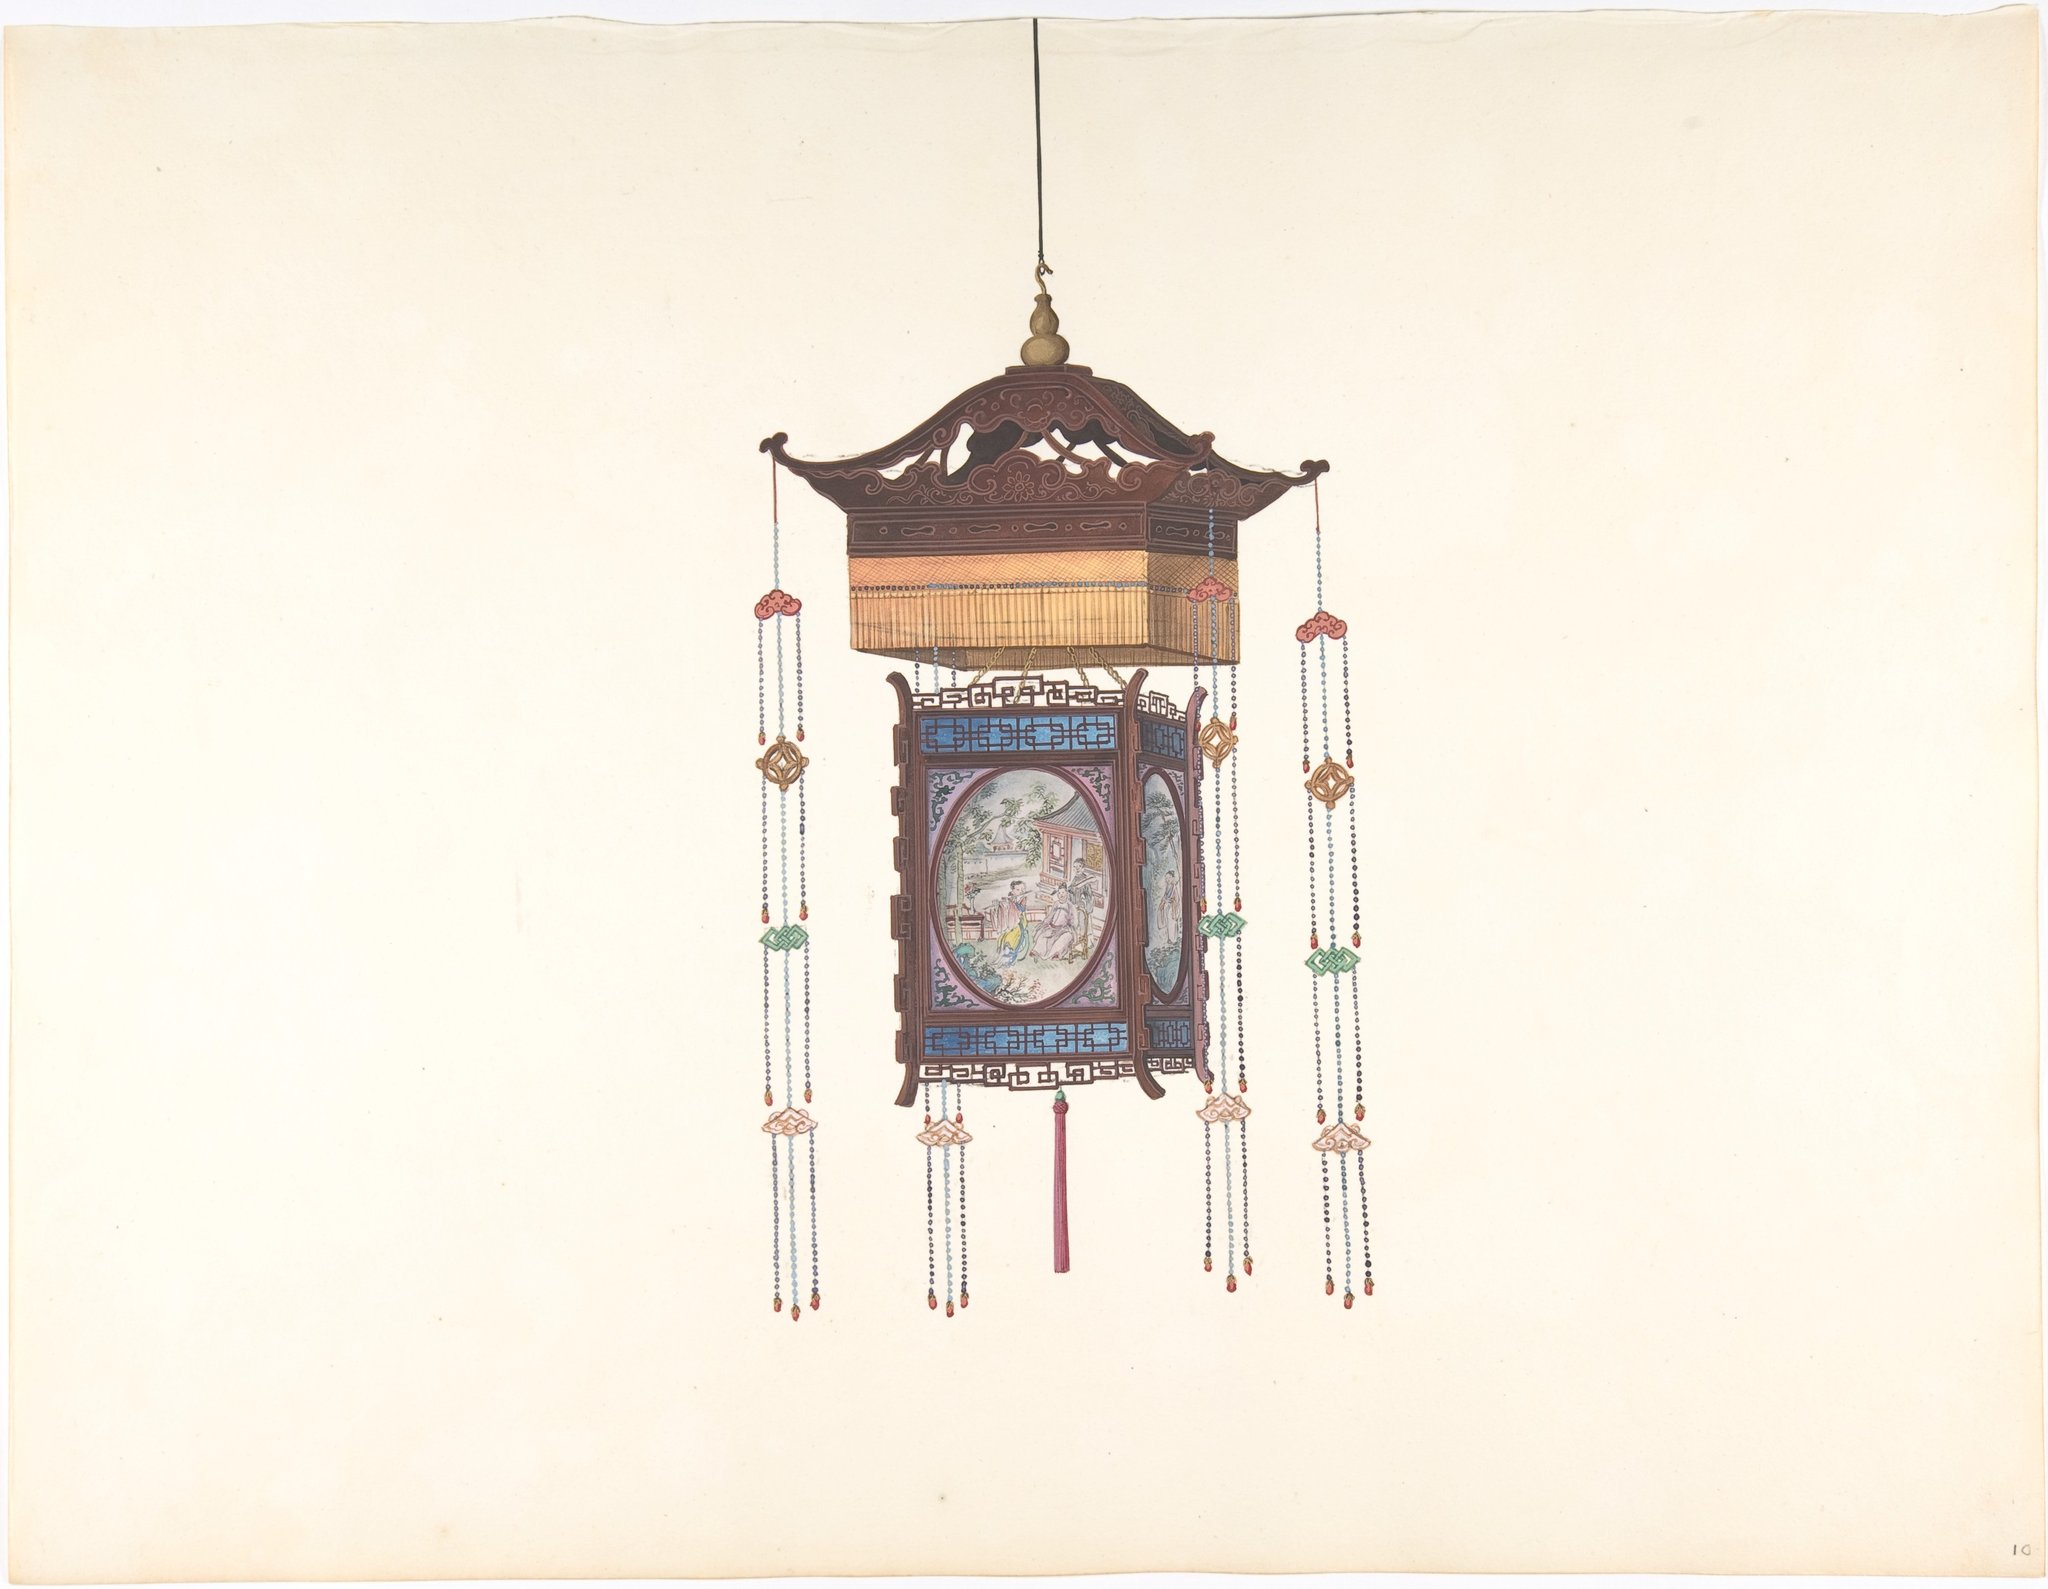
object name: drawing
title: Hanging Lantern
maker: anonymous, chinese, 19th century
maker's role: artist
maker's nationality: chinese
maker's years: 1800-1900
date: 1801-1900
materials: gouache, ink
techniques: pen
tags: lanterns